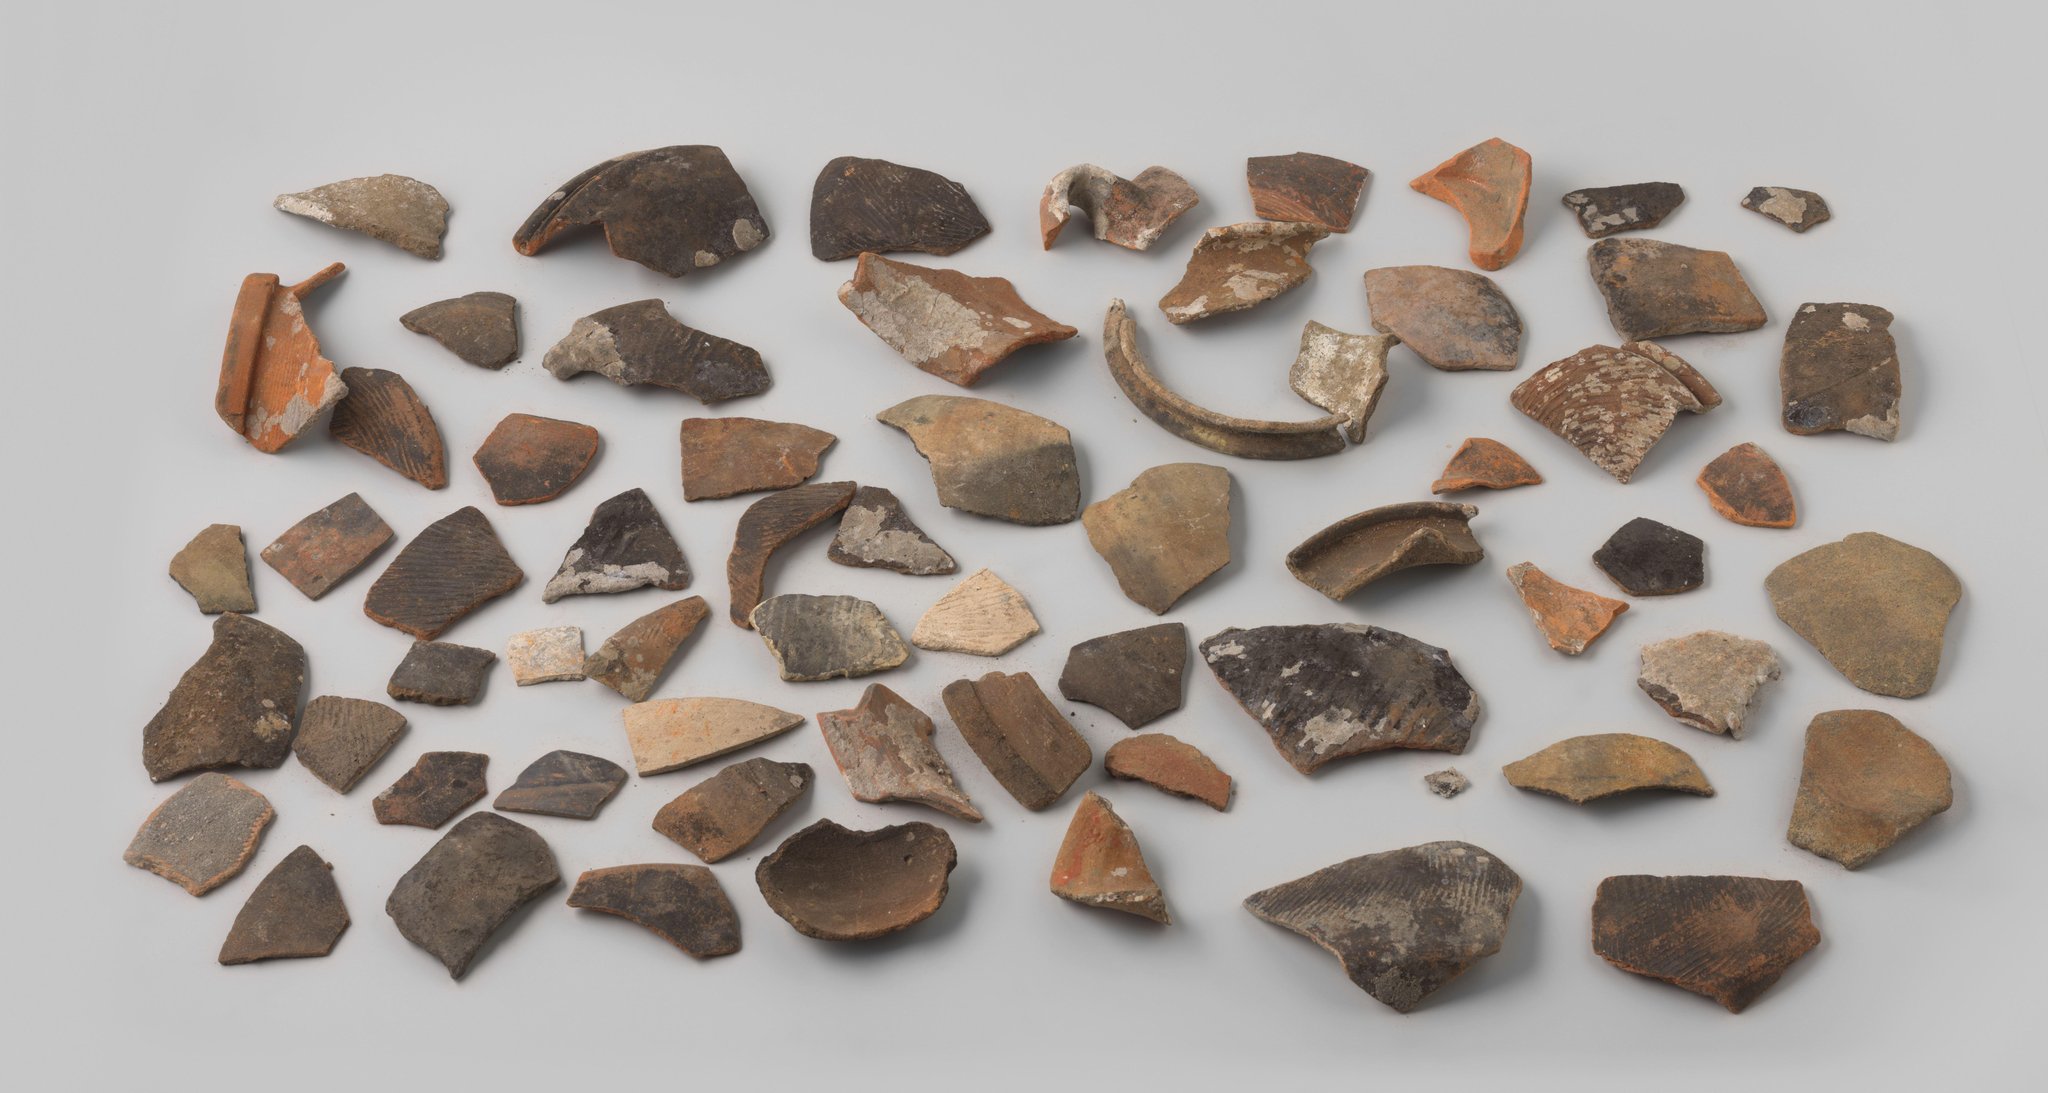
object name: sherd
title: Zak met scherven aardewerk uit V.O.C.-schip de 'Witte Leeuw'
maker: Anonymous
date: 1613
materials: dye, earthenware, stoneware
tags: verenigde oostindische compagnie, sint-helena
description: Zak met scherven van roodbakkend en grijsbakkend aardewerk en steengoed uit V.O.C.-schip de 'Witte Leeuw'. Een aantal zijn met gekraste lijnen versierd, en één scherf heeft sporen van verf.